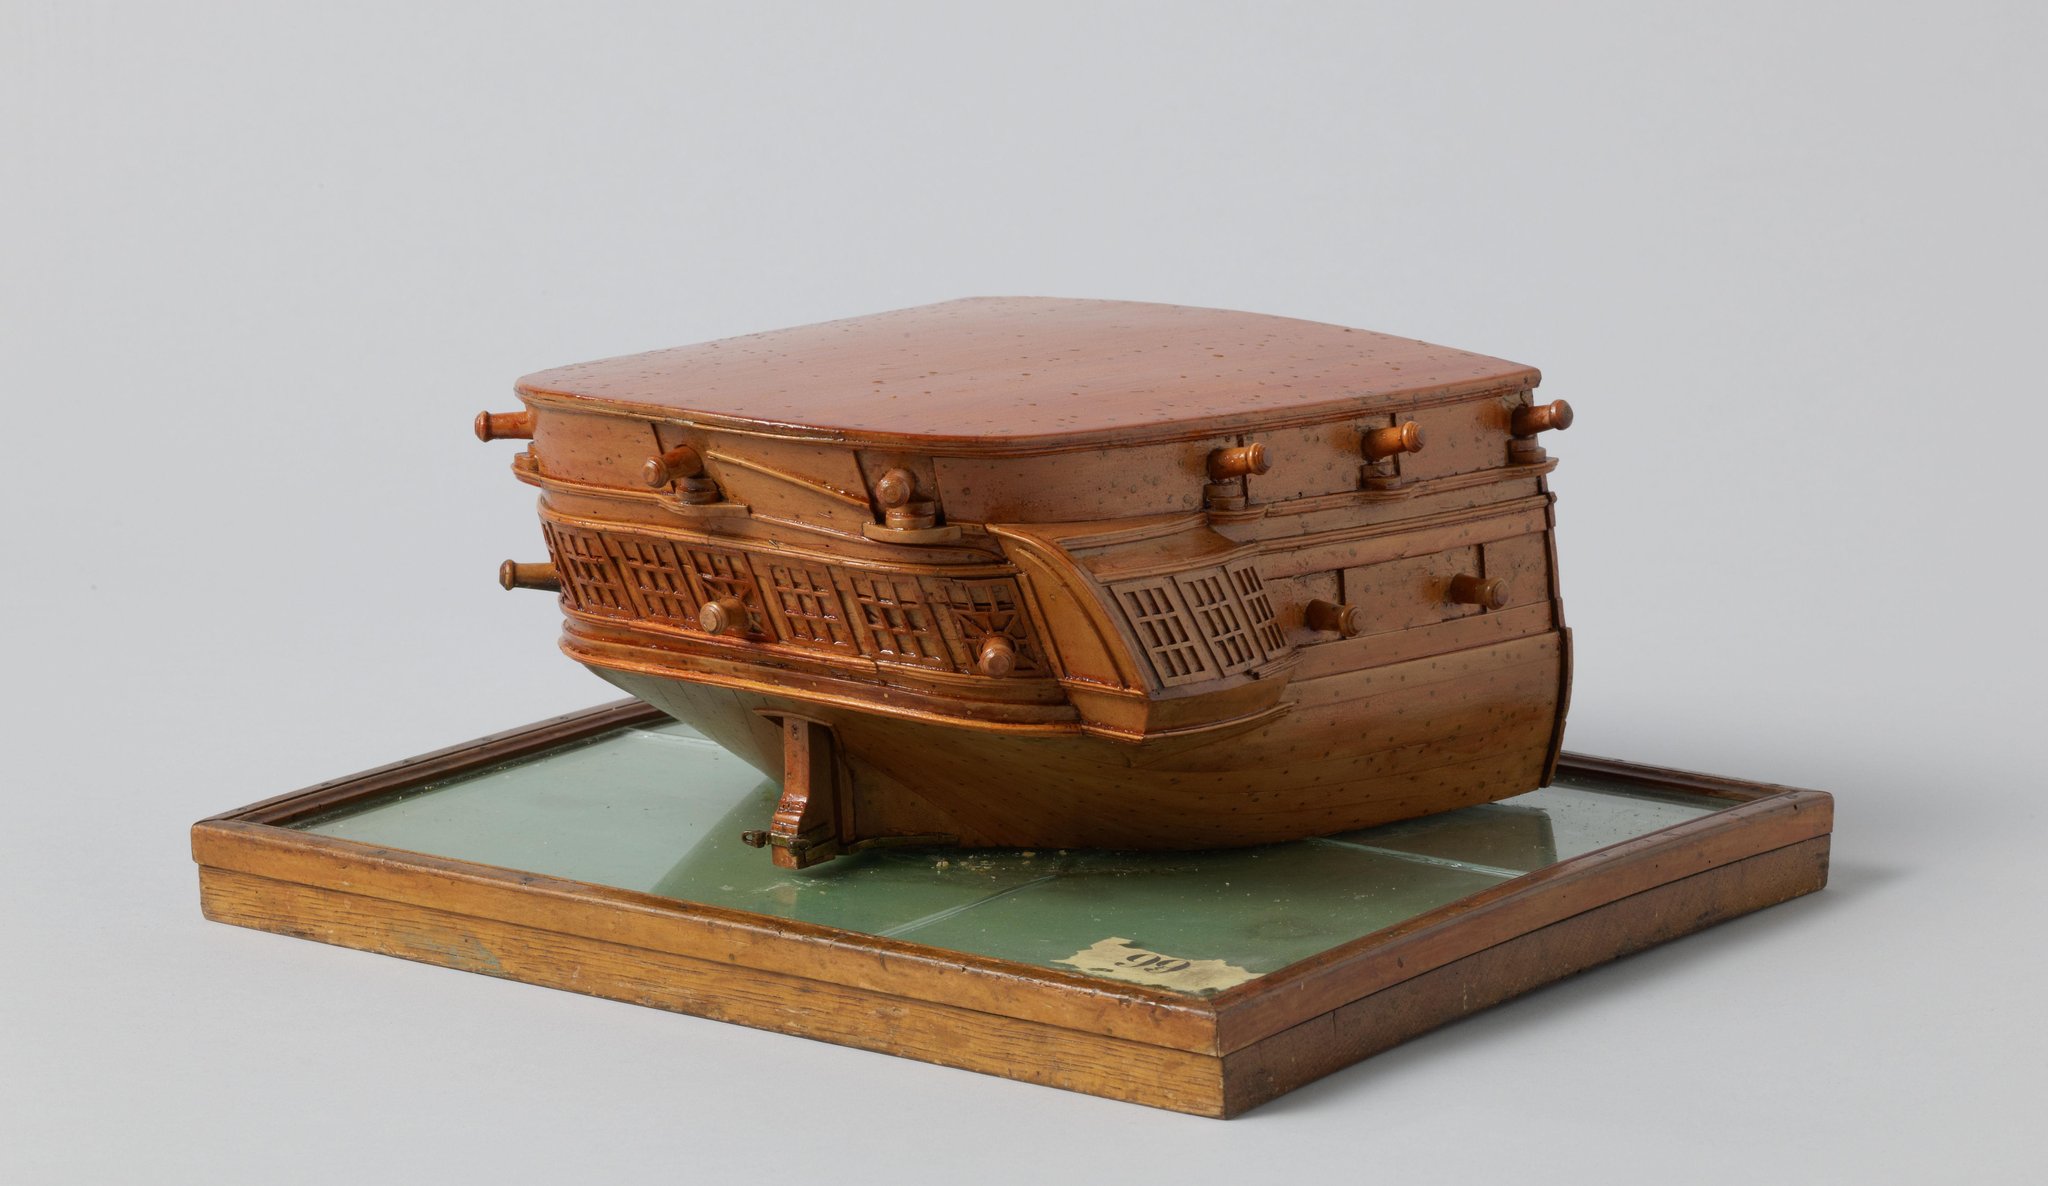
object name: demonstration model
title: Model of the Sterns of Two Different Frigates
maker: Anonymous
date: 1831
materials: brass, glass, paper, wood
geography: netherlands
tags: waal (schip), ijssel (schip)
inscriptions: label, on the base board: ‘99’ former inventory label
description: Blokmodel en waterlijnmodel van een achterschip, aan stuurboord volgens het fregat IJssel, aan bakboord volgens het fregat Waal. Elliptisch hek van één verdieping met een zijgalerij aan stuurboord; recht roer met vierkante roerkoning in driehoekig hennegat. De zeeg loopt naar achteren iets op, een verzonken barkhout. Het model is geplaatst op een grondplank met groen geschilderd papier en glas, water nabootsend.